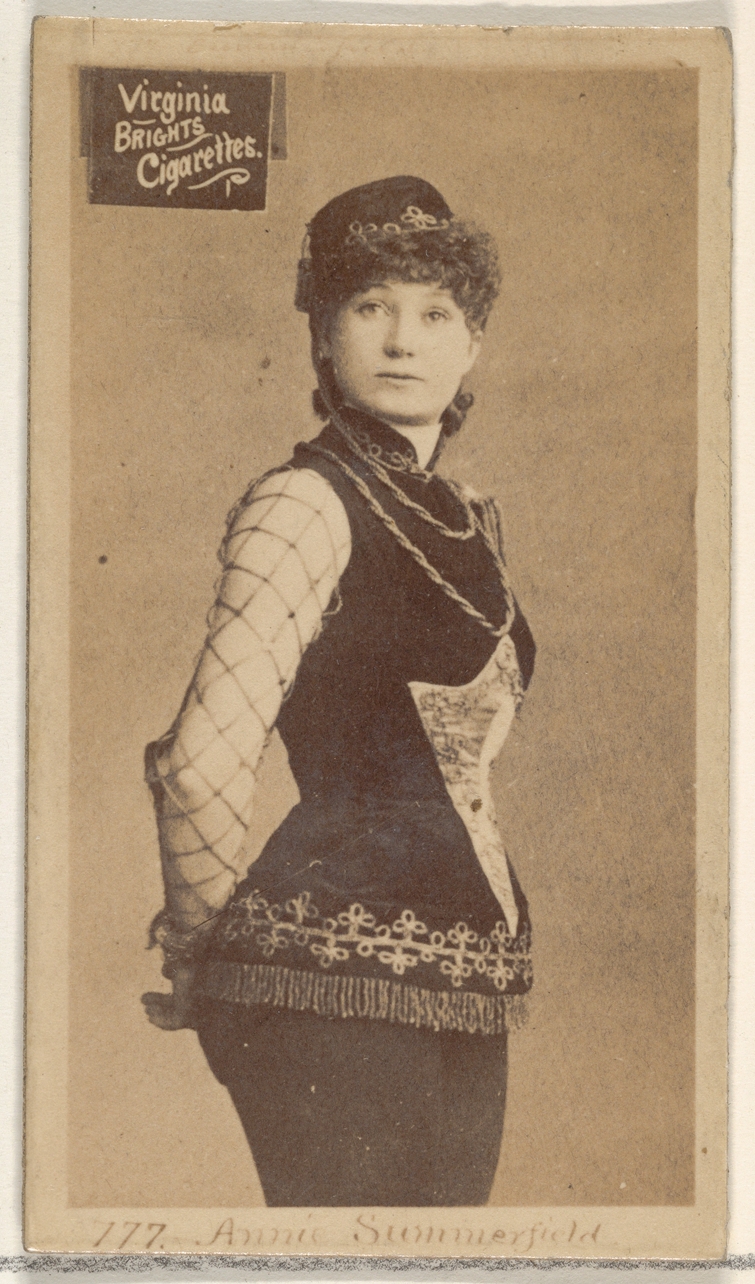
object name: photograph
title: Card 777, Annie Summerfield, from the Actors and Actresses series (N45, Type 2) for Virginia Brights Cigarettes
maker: allen & ginter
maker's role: publisher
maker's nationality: american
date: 1888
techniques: albumen silver print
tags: portraits,women,actresses